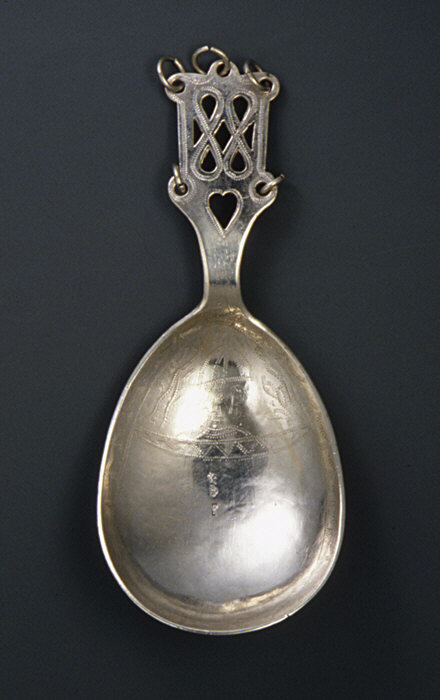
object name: spoon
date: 1752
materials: silver